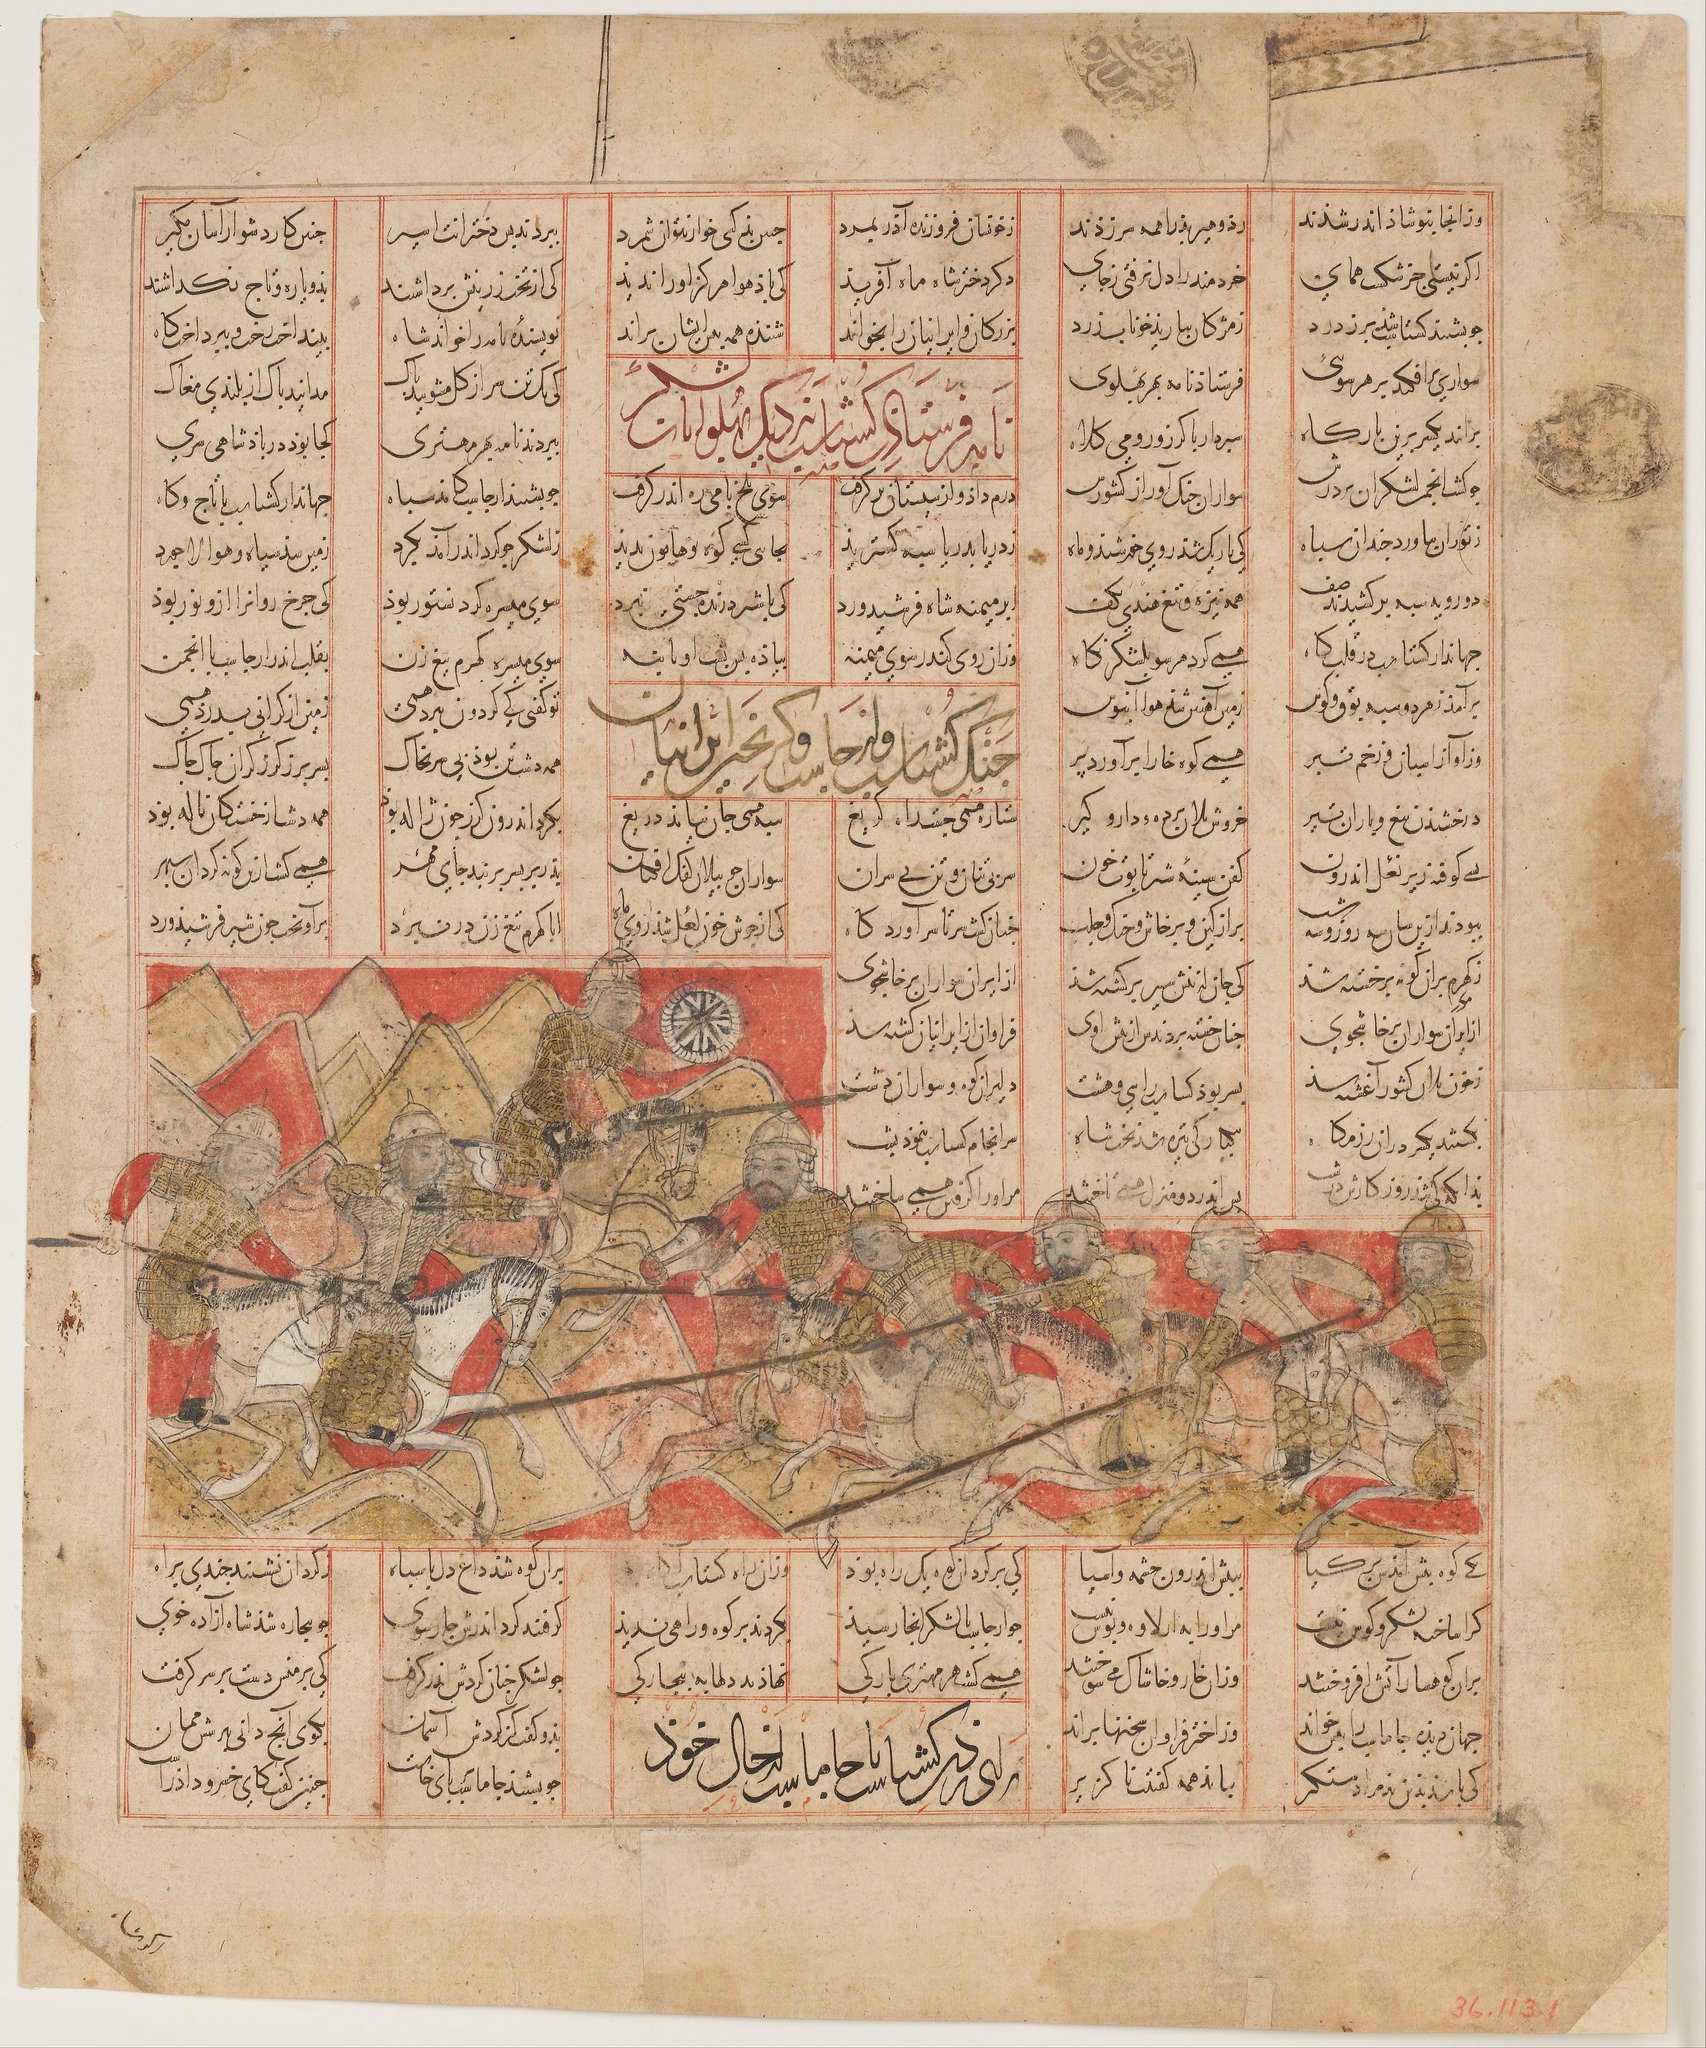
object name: folio from an illustrated manuscript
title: "Iranian and Turanian Armies in Combat", Folio from a Shahnama (Book of Kings)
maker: abu'l qasim firdausi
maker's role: author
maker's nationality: iranian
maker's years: 935-1020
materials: gold, ink, paper, watercolor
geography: iran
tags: battles,soldiers,horses